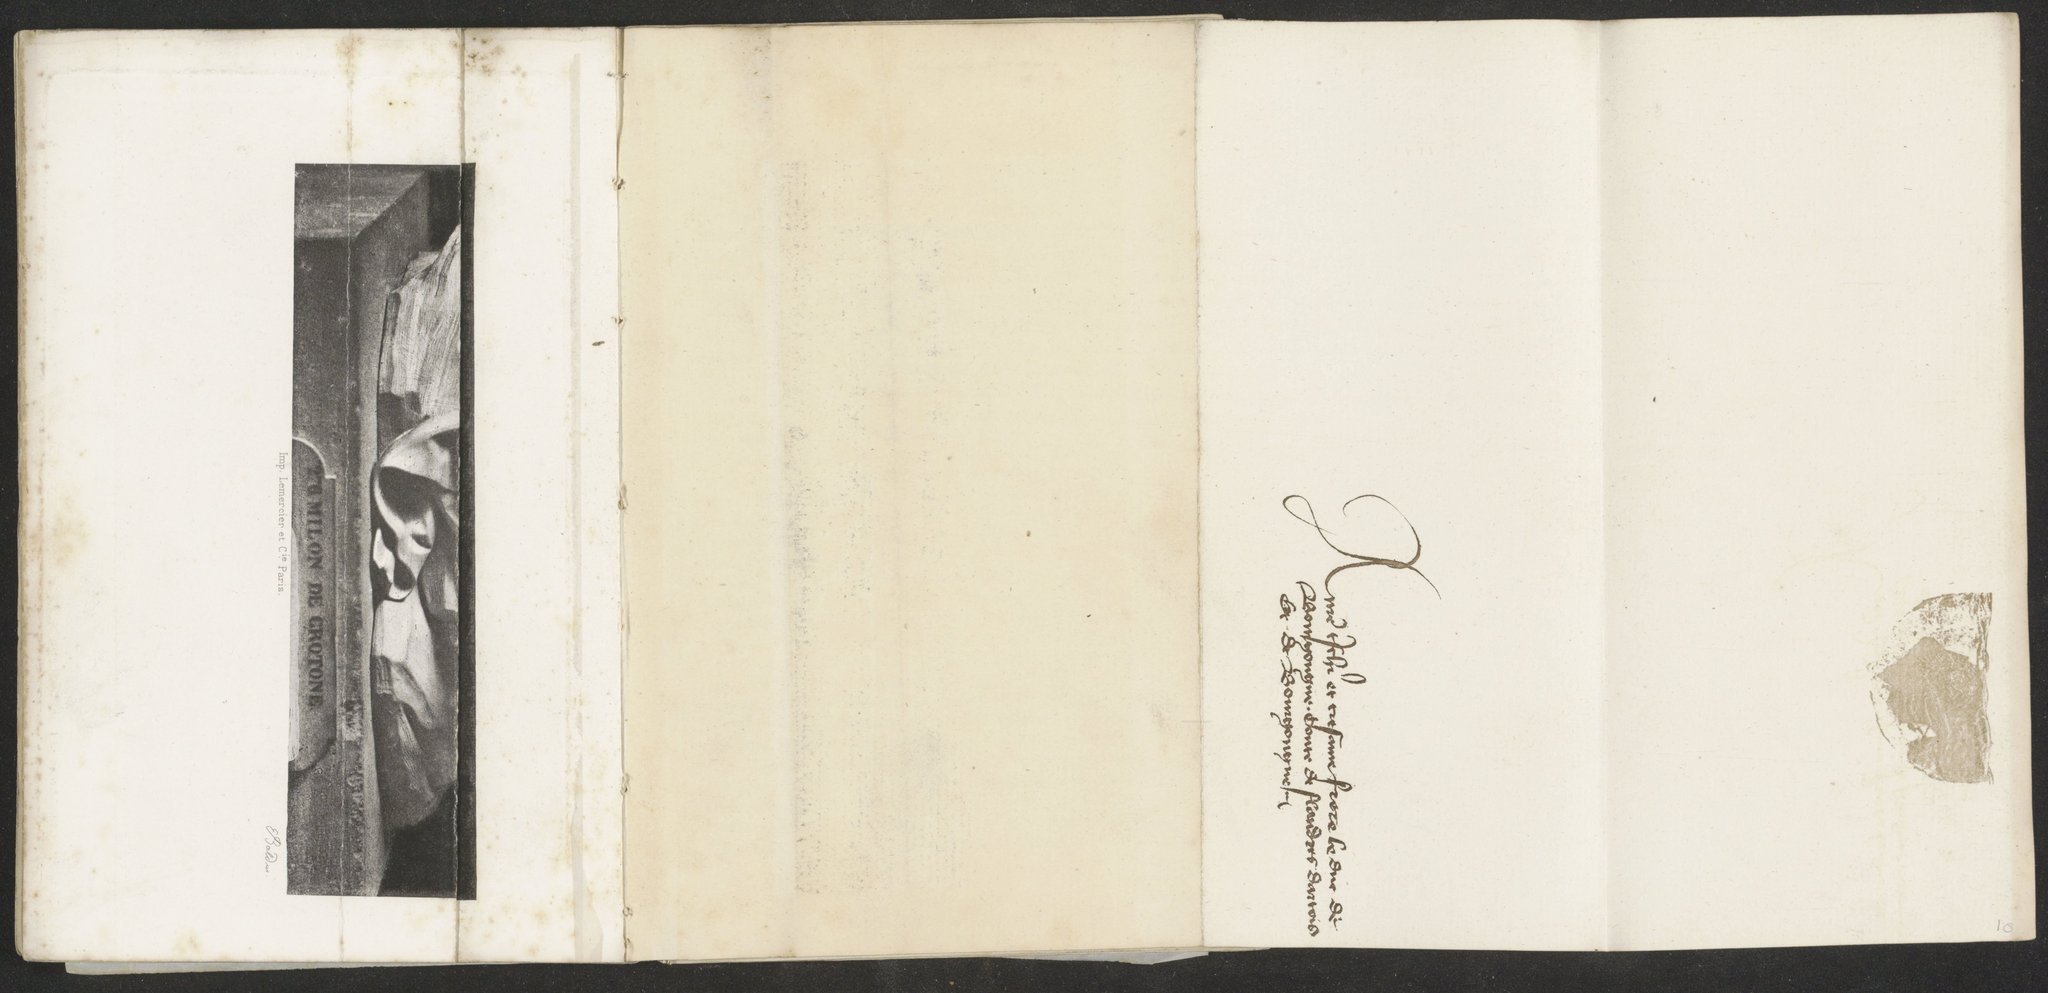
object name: page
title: Fotoreproductie van een tekst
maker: Anonymous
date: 1859-1869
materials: paper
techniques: photolithography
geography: france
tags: handwriting, written text